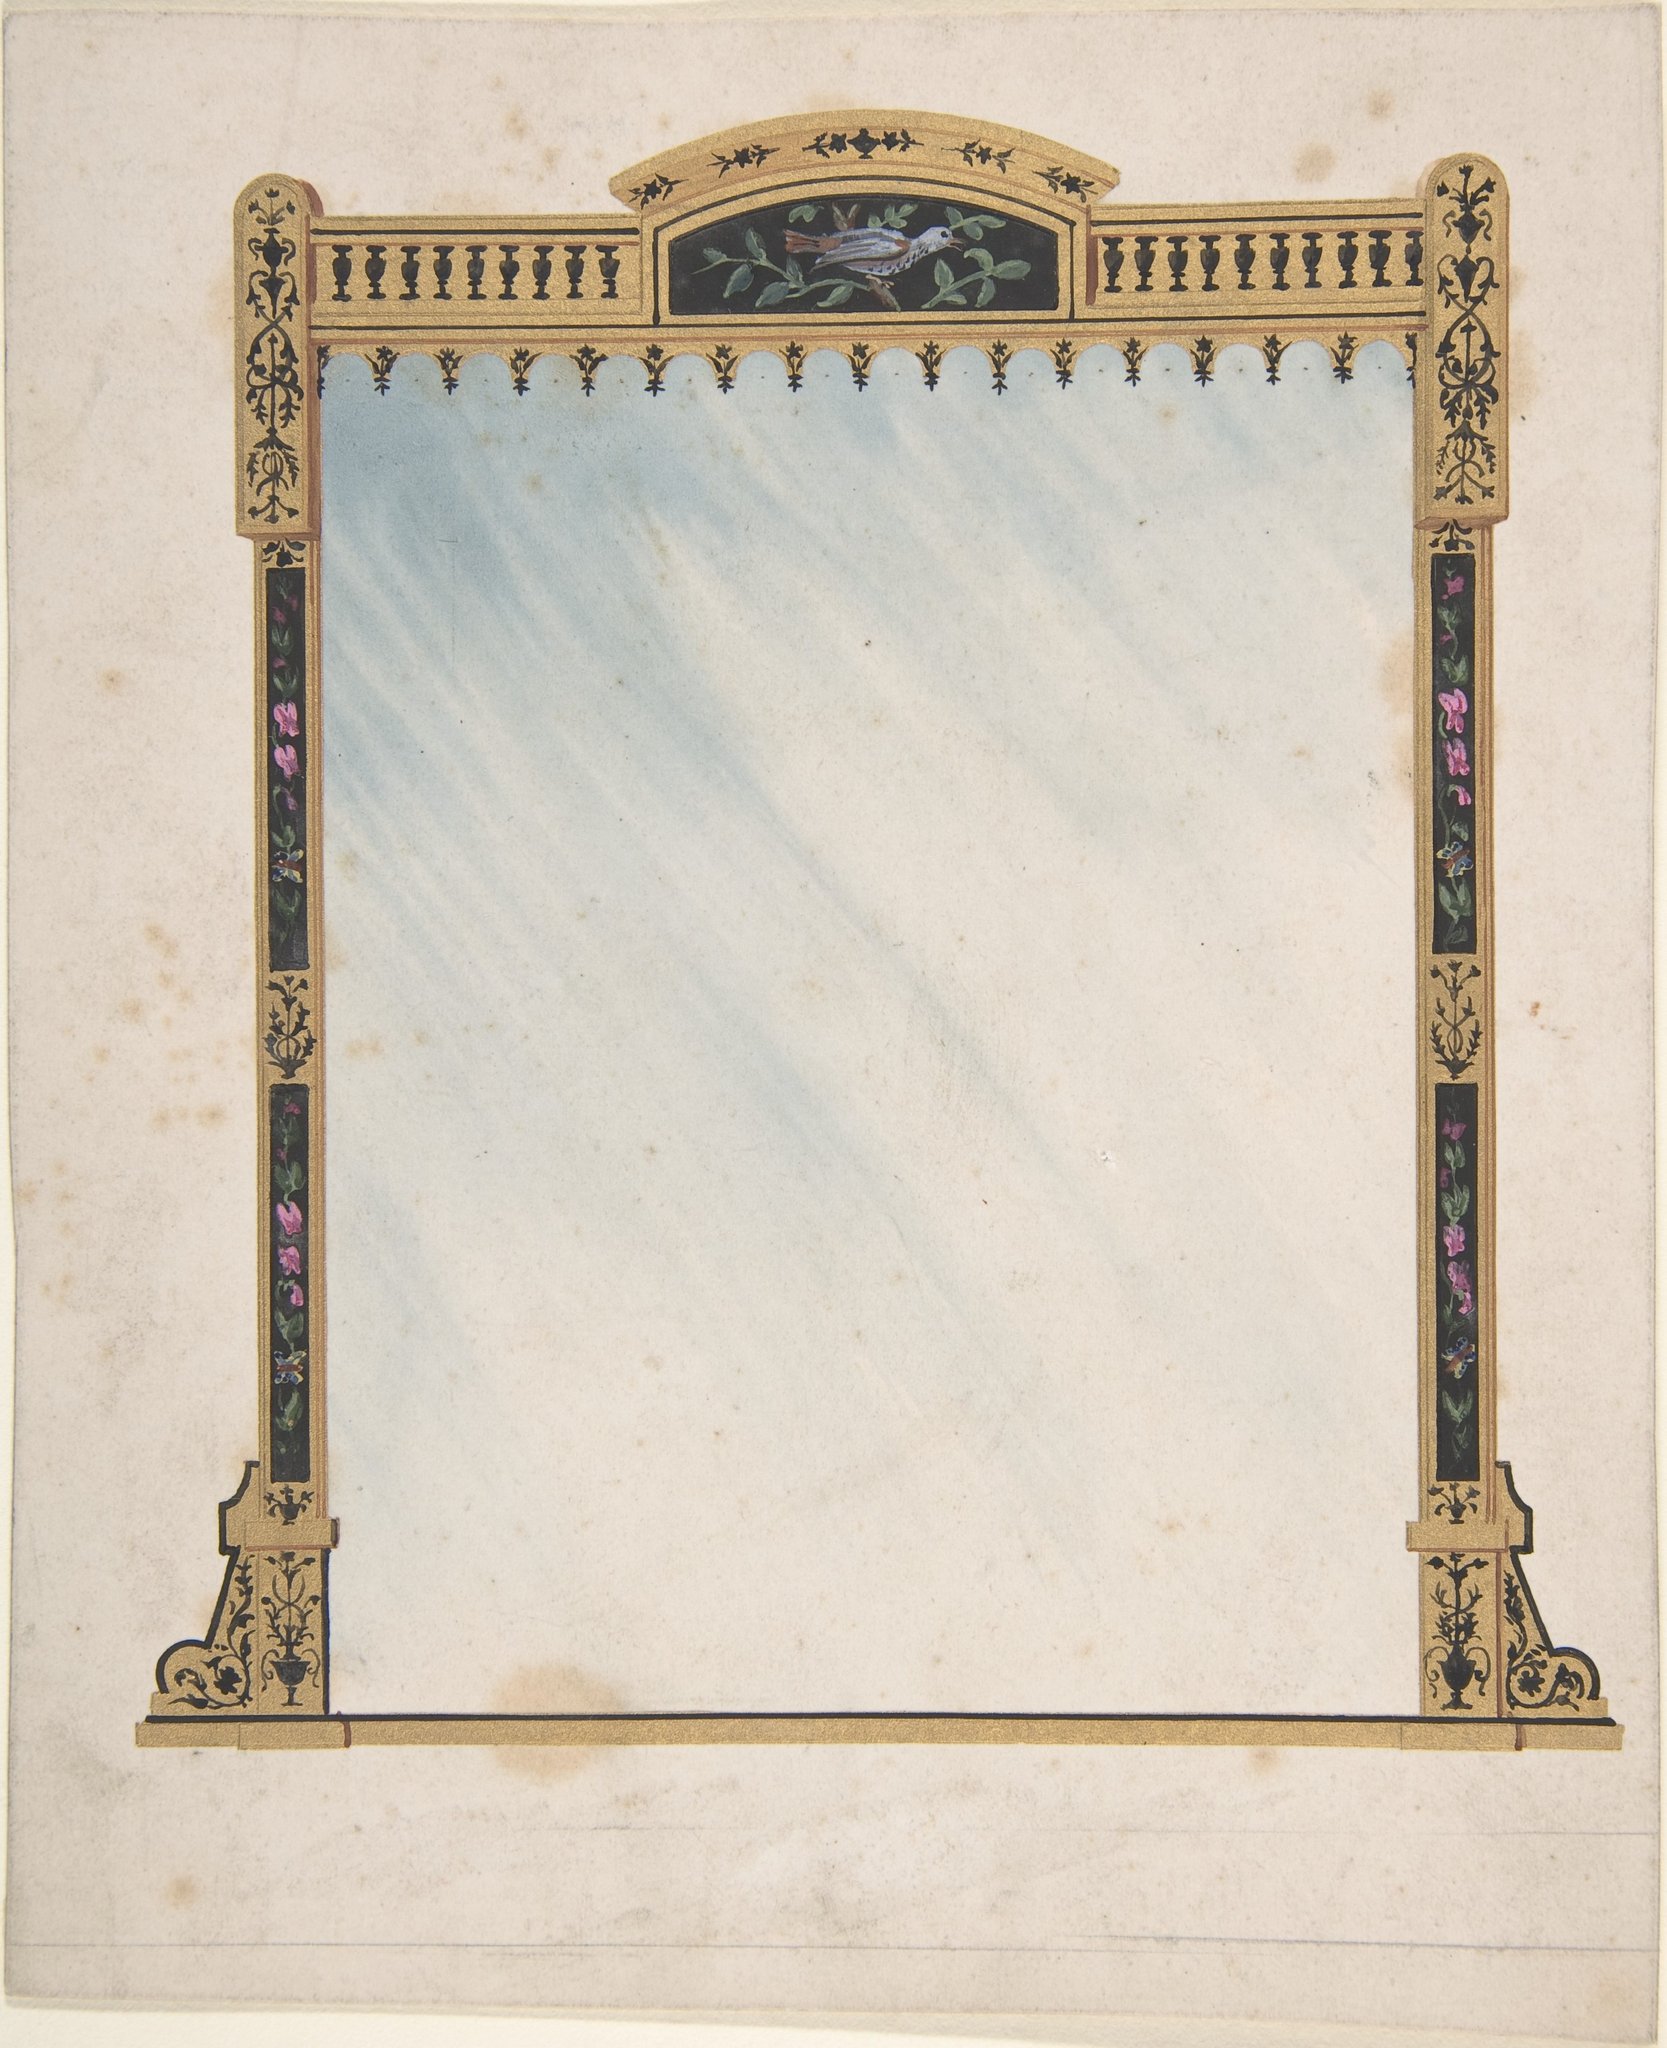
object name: drawing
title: Design for a Mirror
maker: anonymous, british, 19th century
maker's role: artist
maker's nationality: british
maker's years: 1800-1900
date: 1820-1880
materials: gouache, ink, watercolor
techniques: pen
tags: birds,mirrors